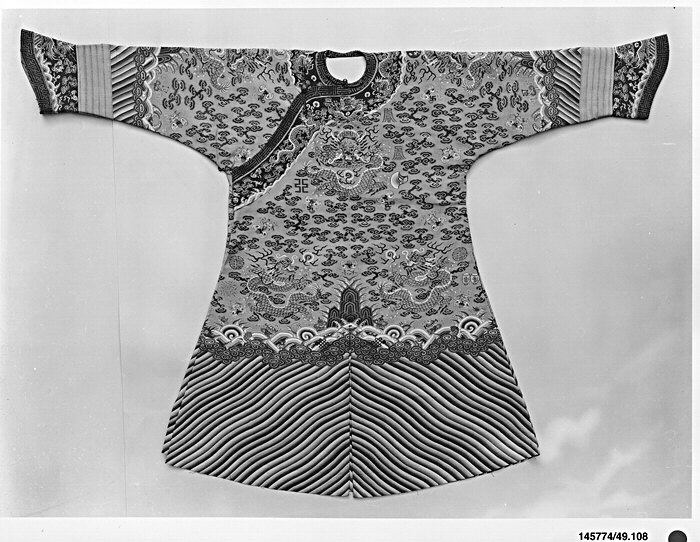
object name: robe, imperial twelve symbol for boy emperor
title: Imperial Twelve-Symbol Robe for Boy Emperor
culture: chinese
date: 1862-1908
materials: metal thread, silk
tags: dragons